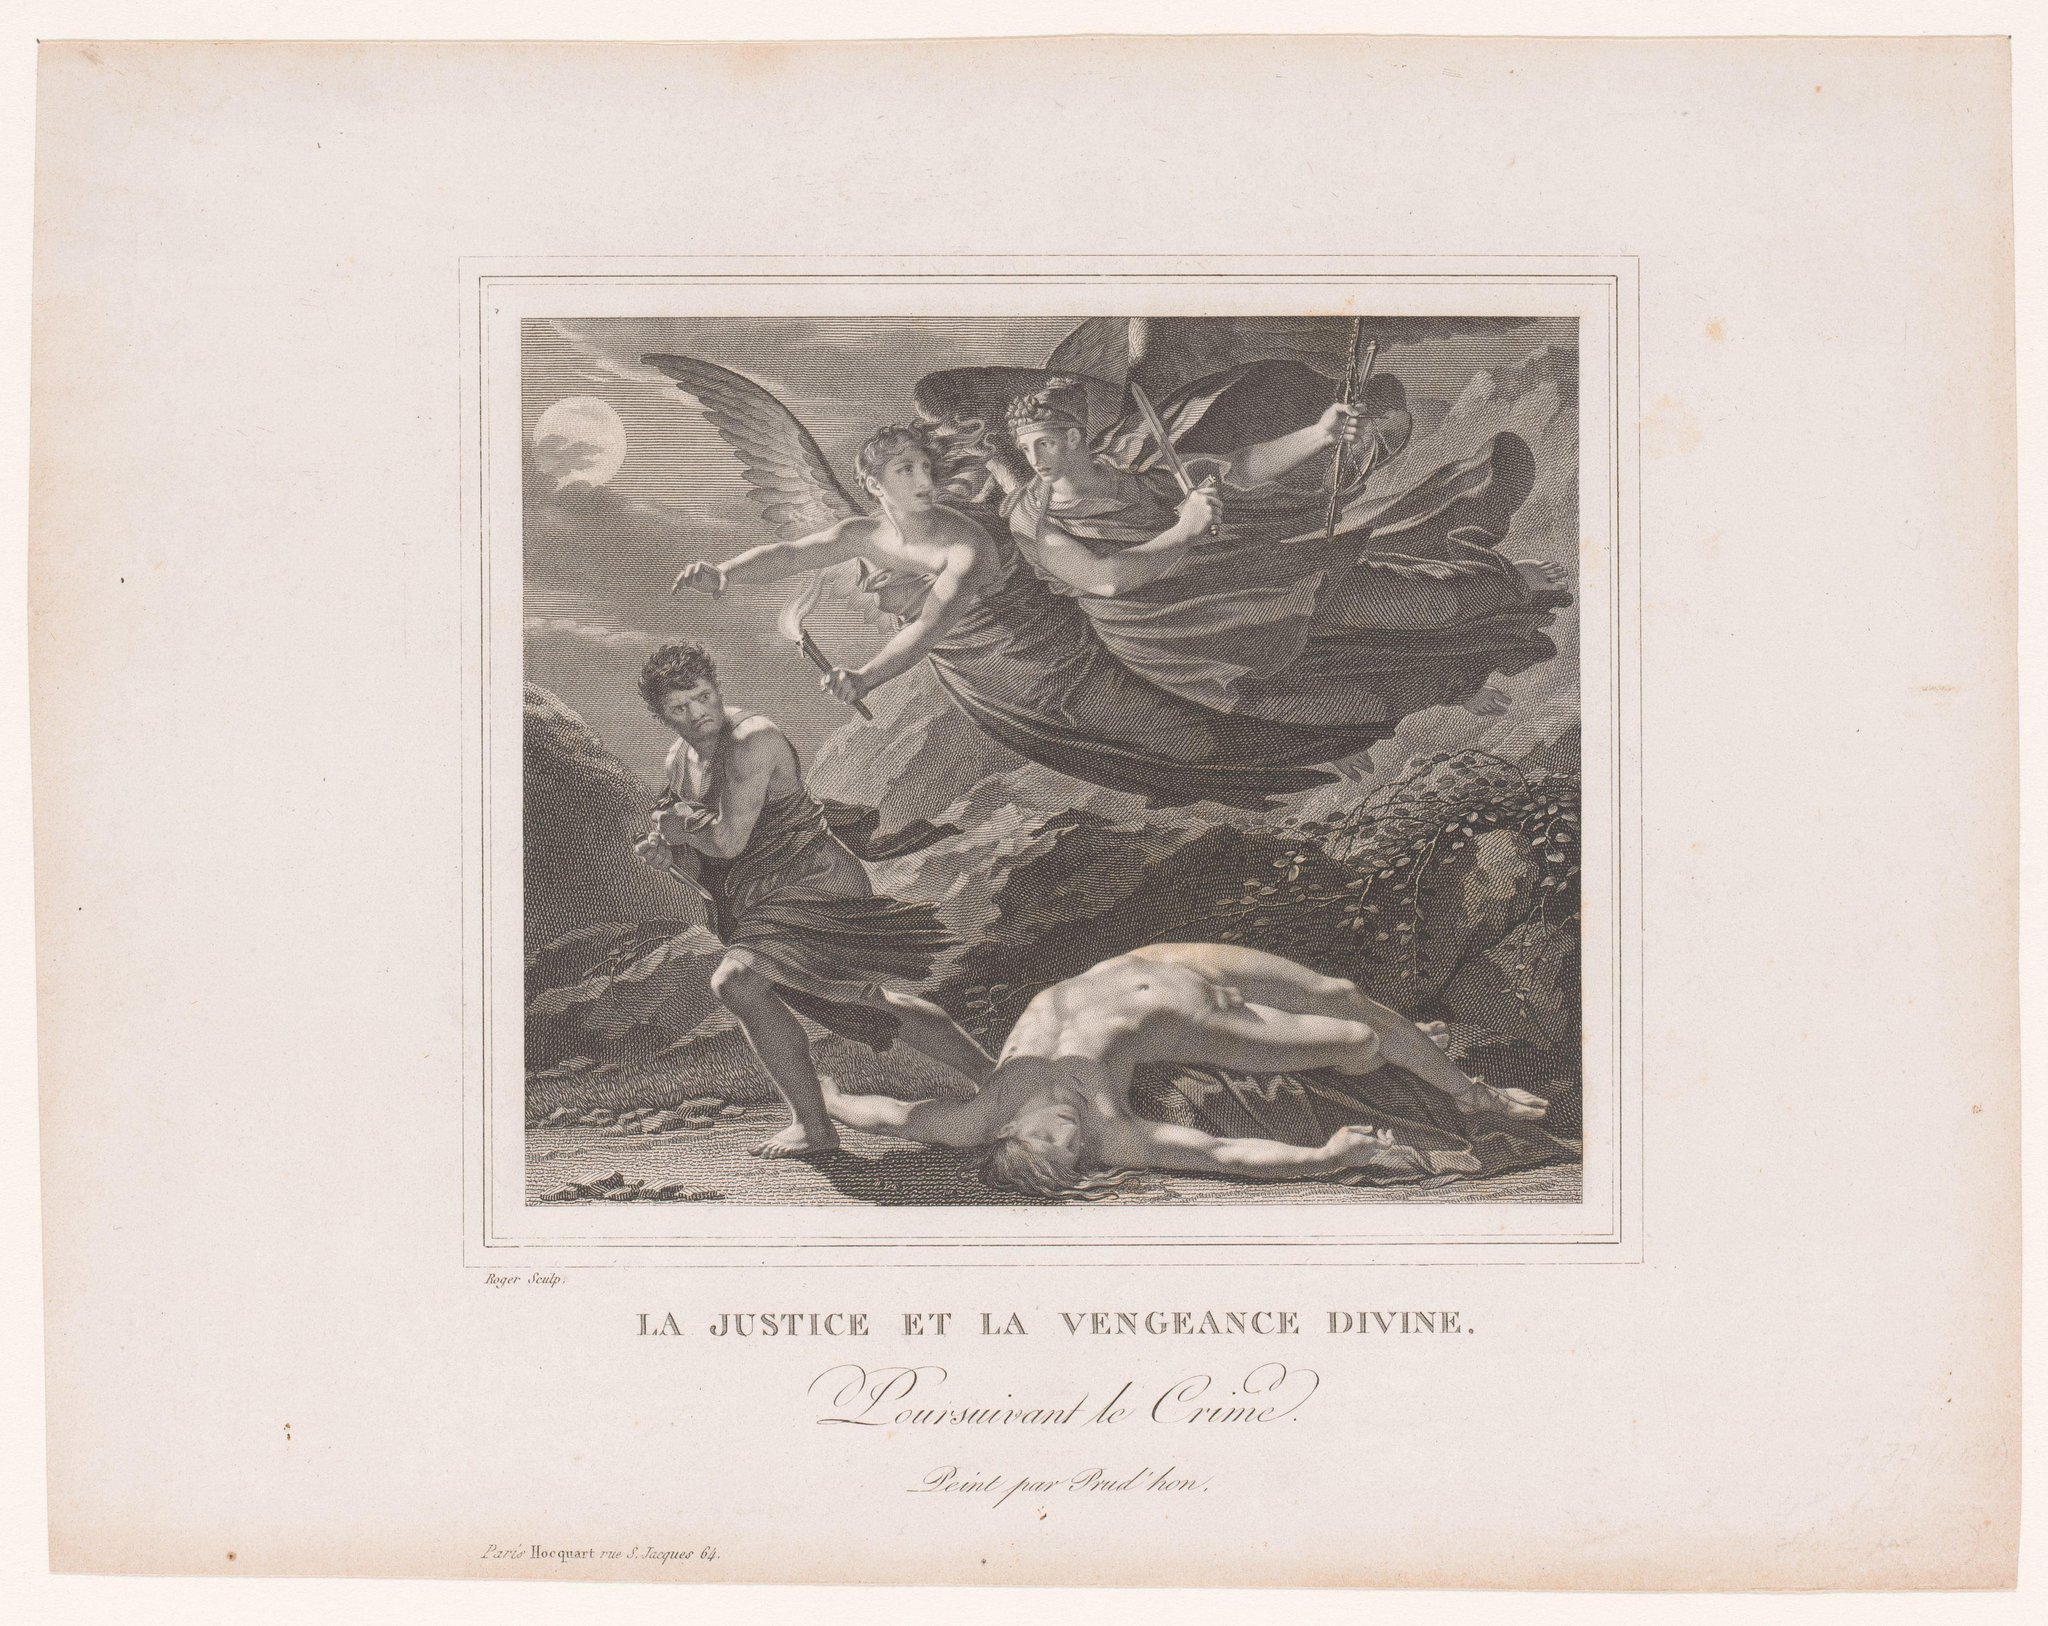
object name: print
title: La Justice et la Vengeance Divine poursuivant le Crime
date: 1806-1841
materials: paper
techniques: engraving, etching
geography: paris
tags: nemesis (adrastea), crime, themis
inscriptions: collector's mark: Lugt 2228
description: Nemesis (Goddelijke Wraak) en Themis (Rechtvaardigheid) achtervolgen Misdaad.